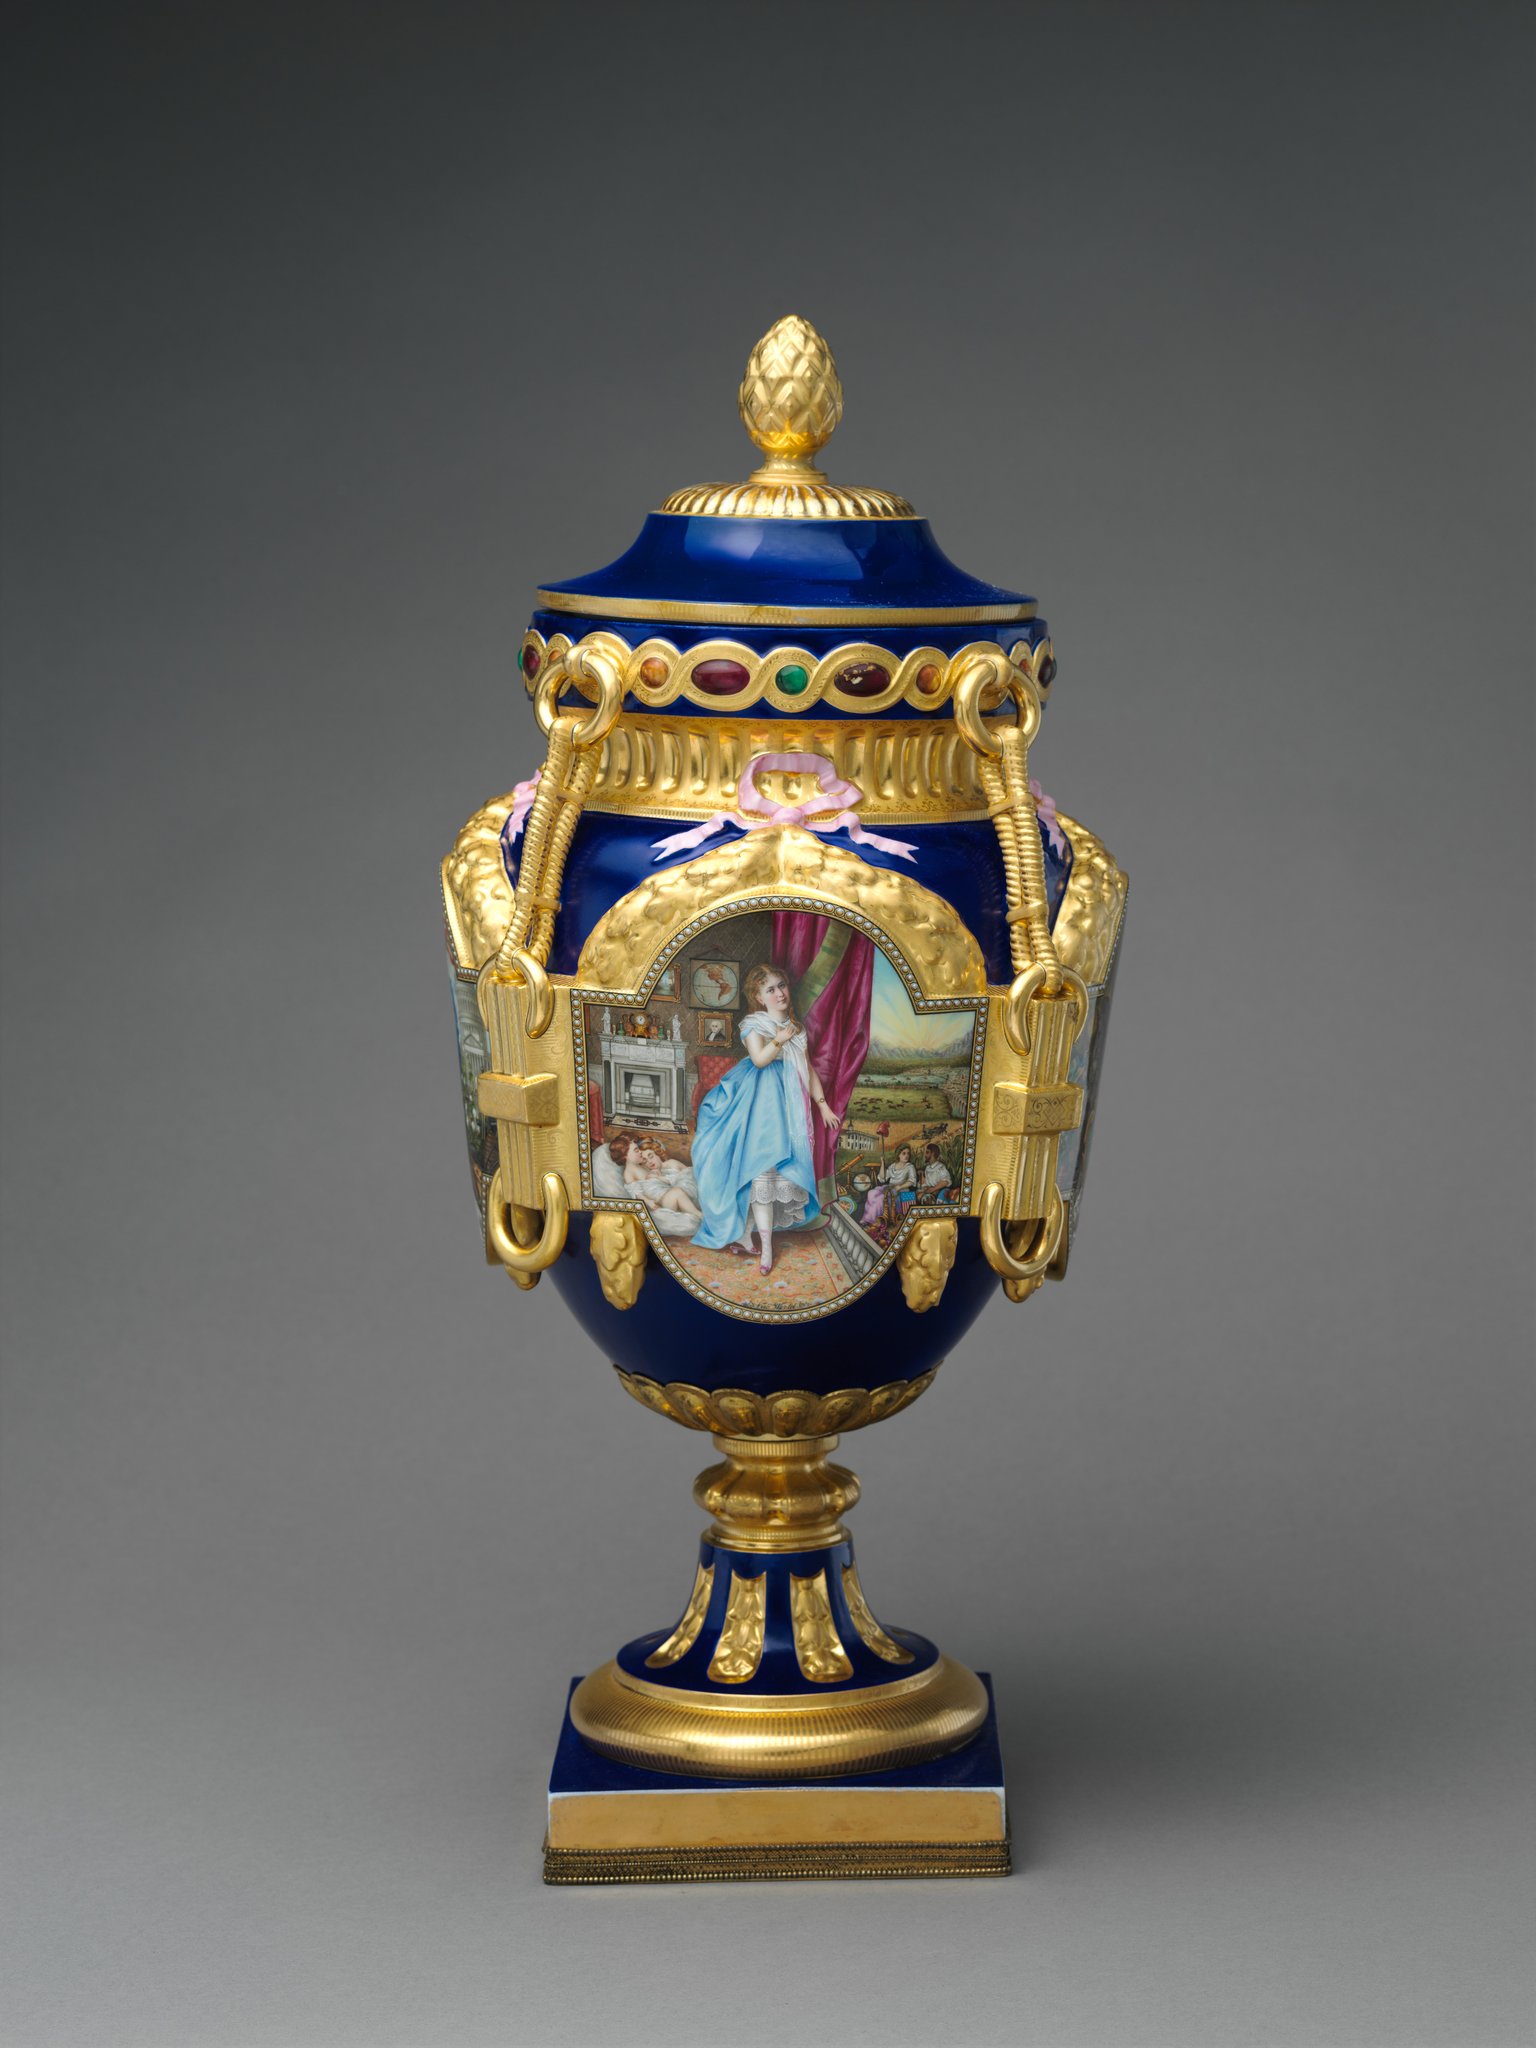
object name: vase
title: Vase (New World)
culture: american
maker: joseph s. potter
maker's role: artist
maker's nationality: american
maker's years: 1822-1904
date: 1886-1889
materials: porcelain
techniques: enamel, gilding